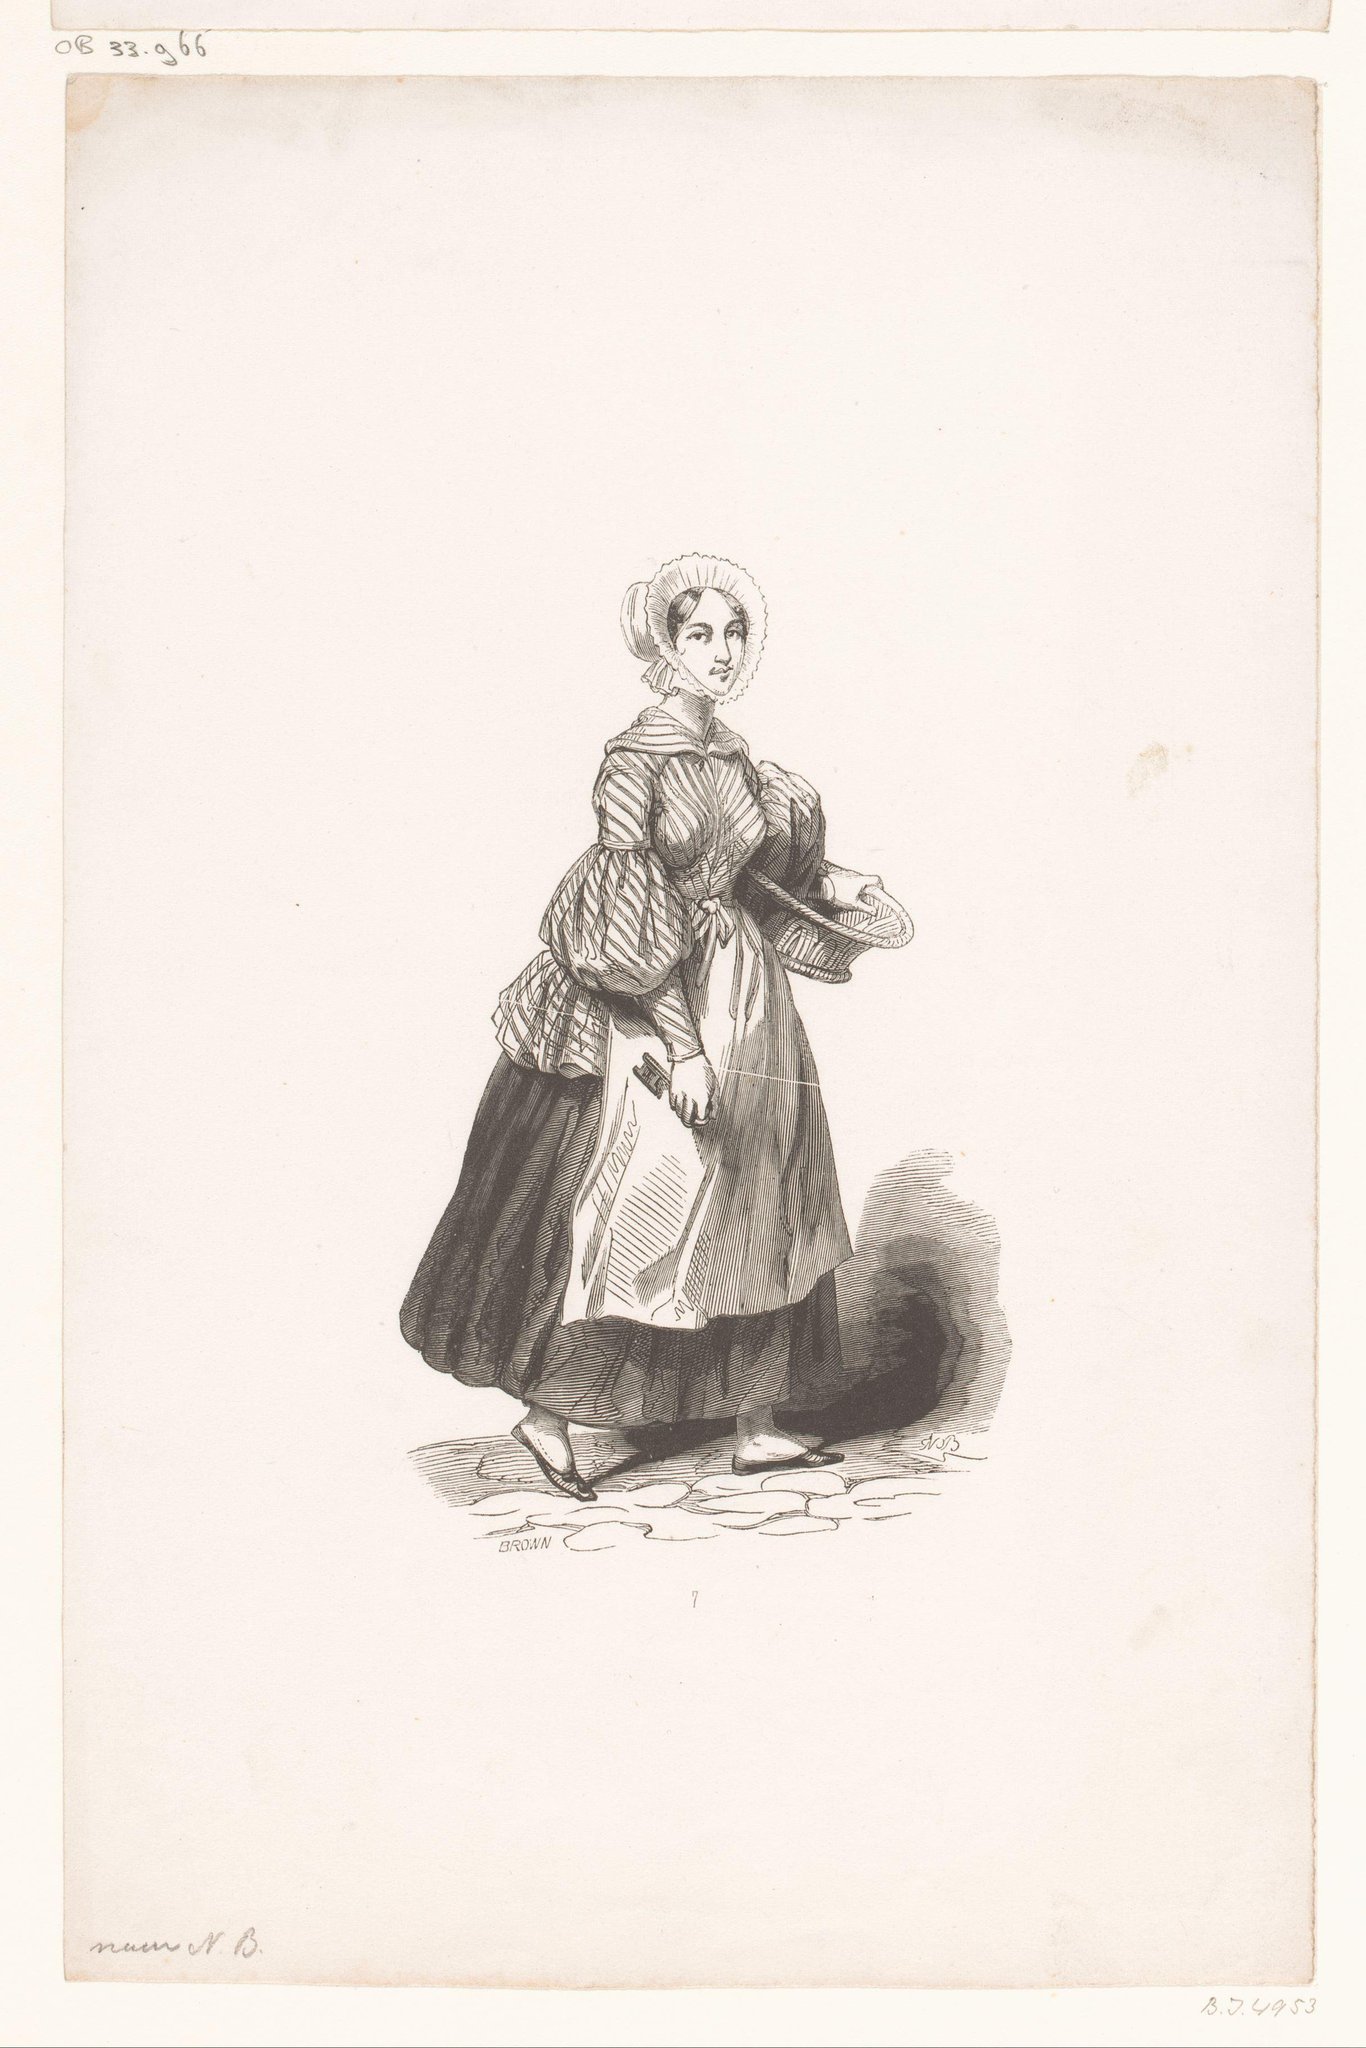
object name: print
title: Vrouw met mand en sleutel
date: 1841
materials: paper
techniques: engraving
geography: the hague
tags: adult woman, key, container made of plant material other than wood: basket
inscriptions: collector's mark: Lugt 2228, mark: ‘NB’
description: Prent uit: Brown, Henry. De Nederlanden: karakterschetsen, kleederdragten, houding en voorkomen van verschillende standen. Den Haag: Nederlandsche Maatschappij van Schoone Kunsten, 1841.